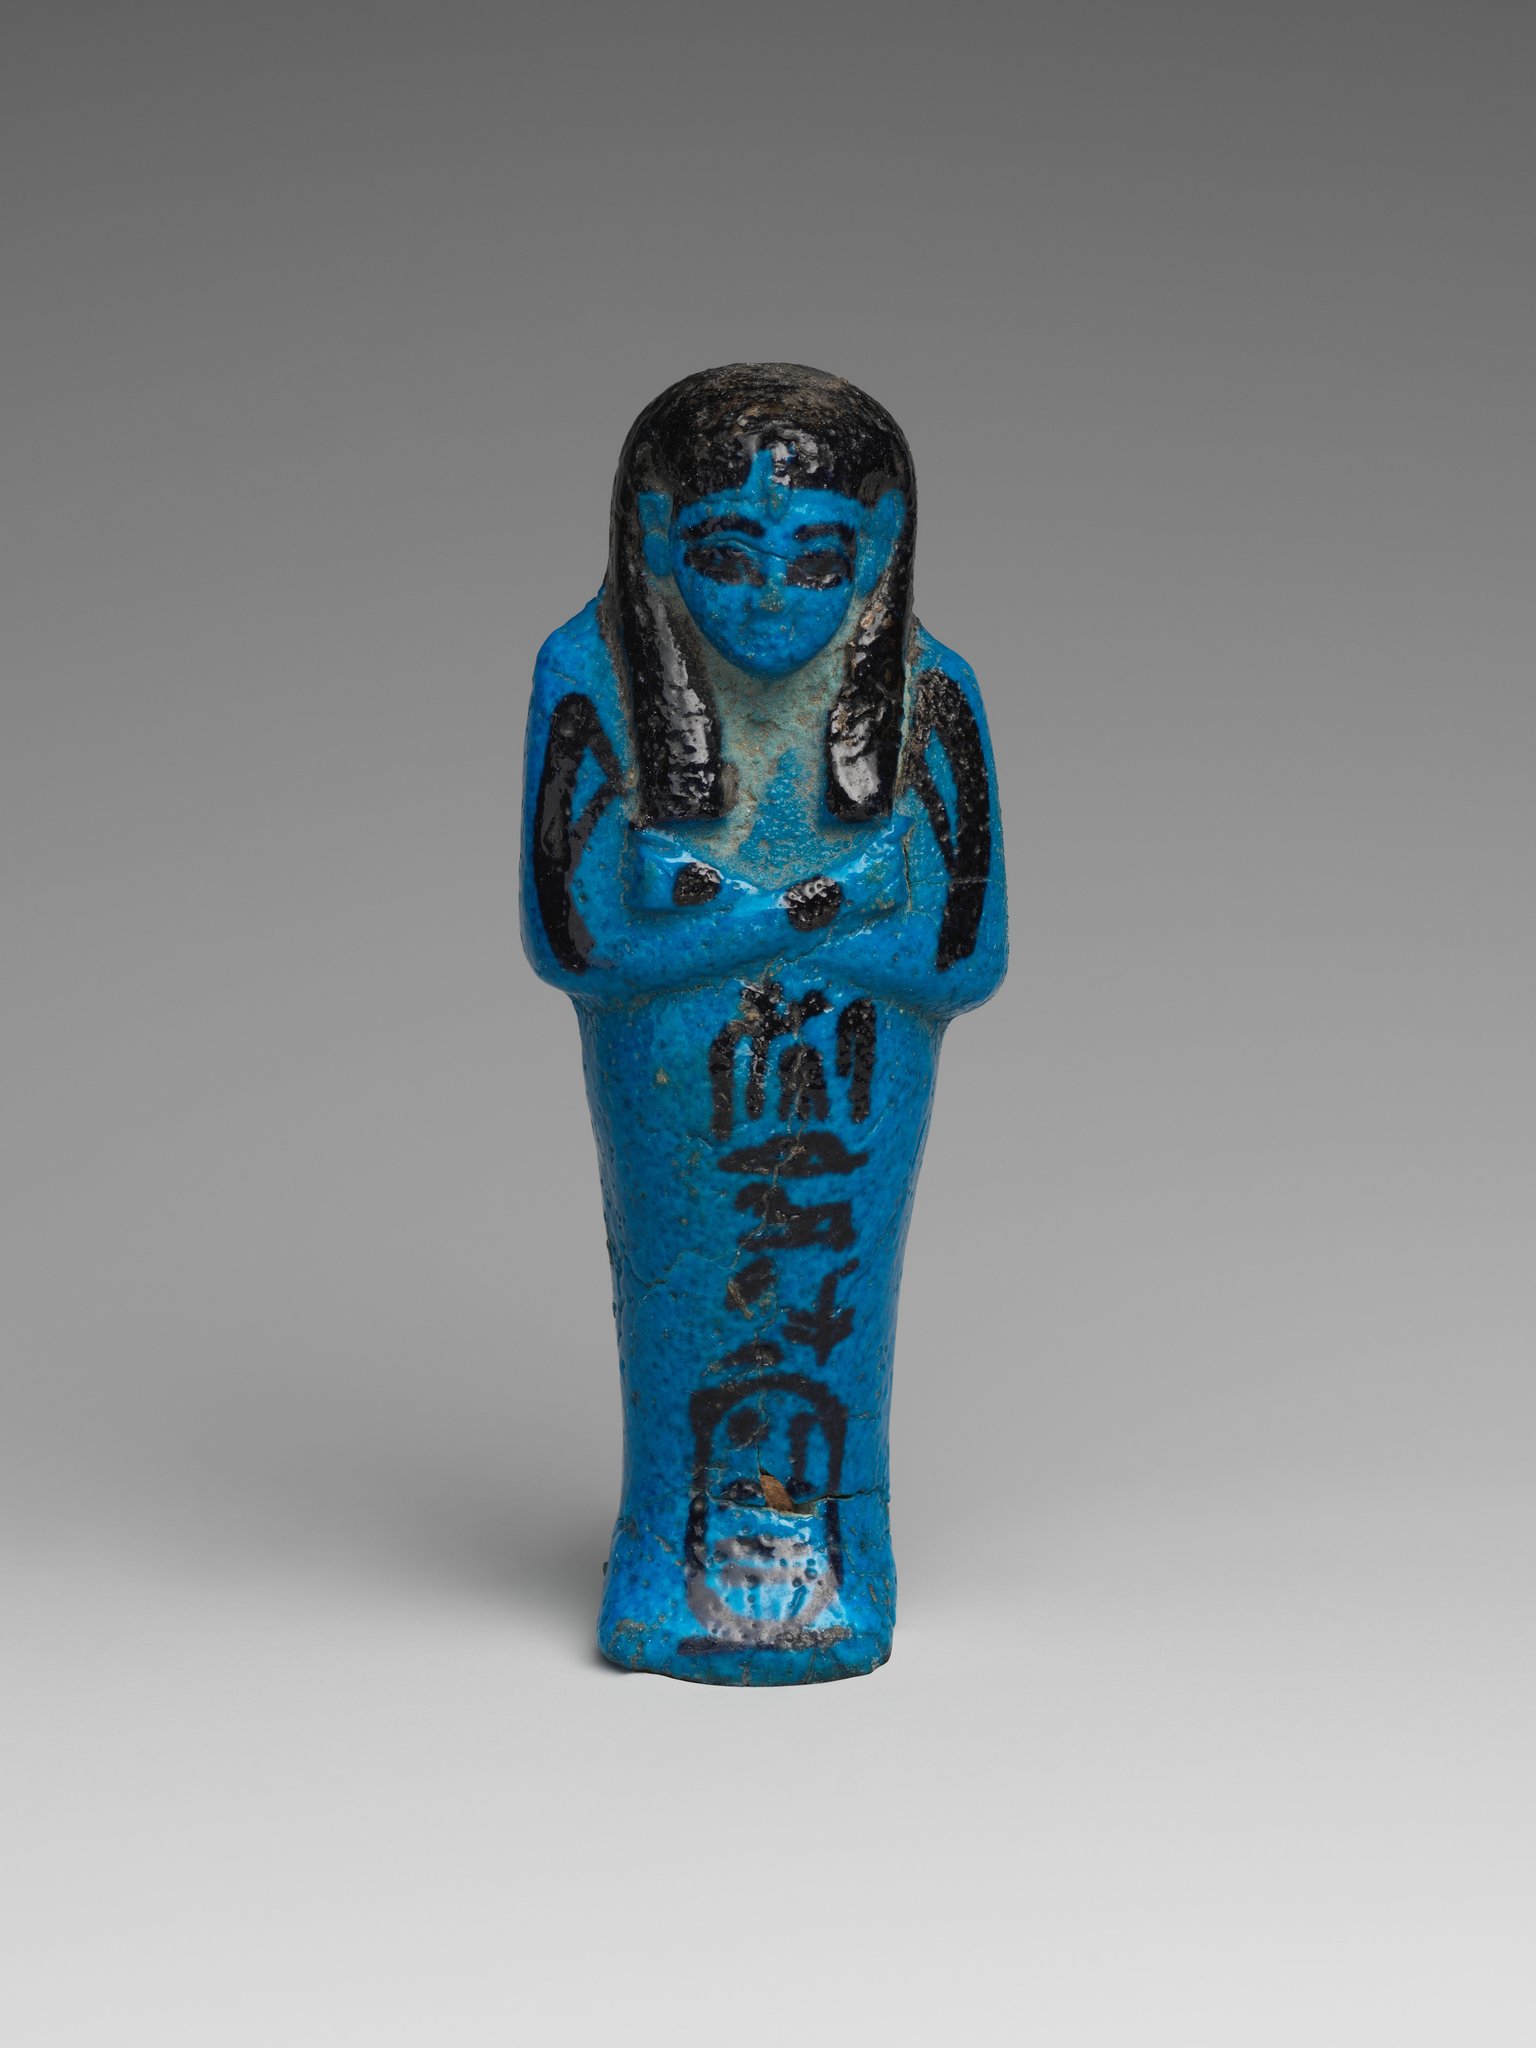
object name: shabti, queen henettawy, duahathor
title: Shabti of the Adoratrice of Hathor ("Duahathor") Henettawy, wife of Painedjem I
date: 1064-1055 BCE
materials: faience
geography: upper egypt, thebes